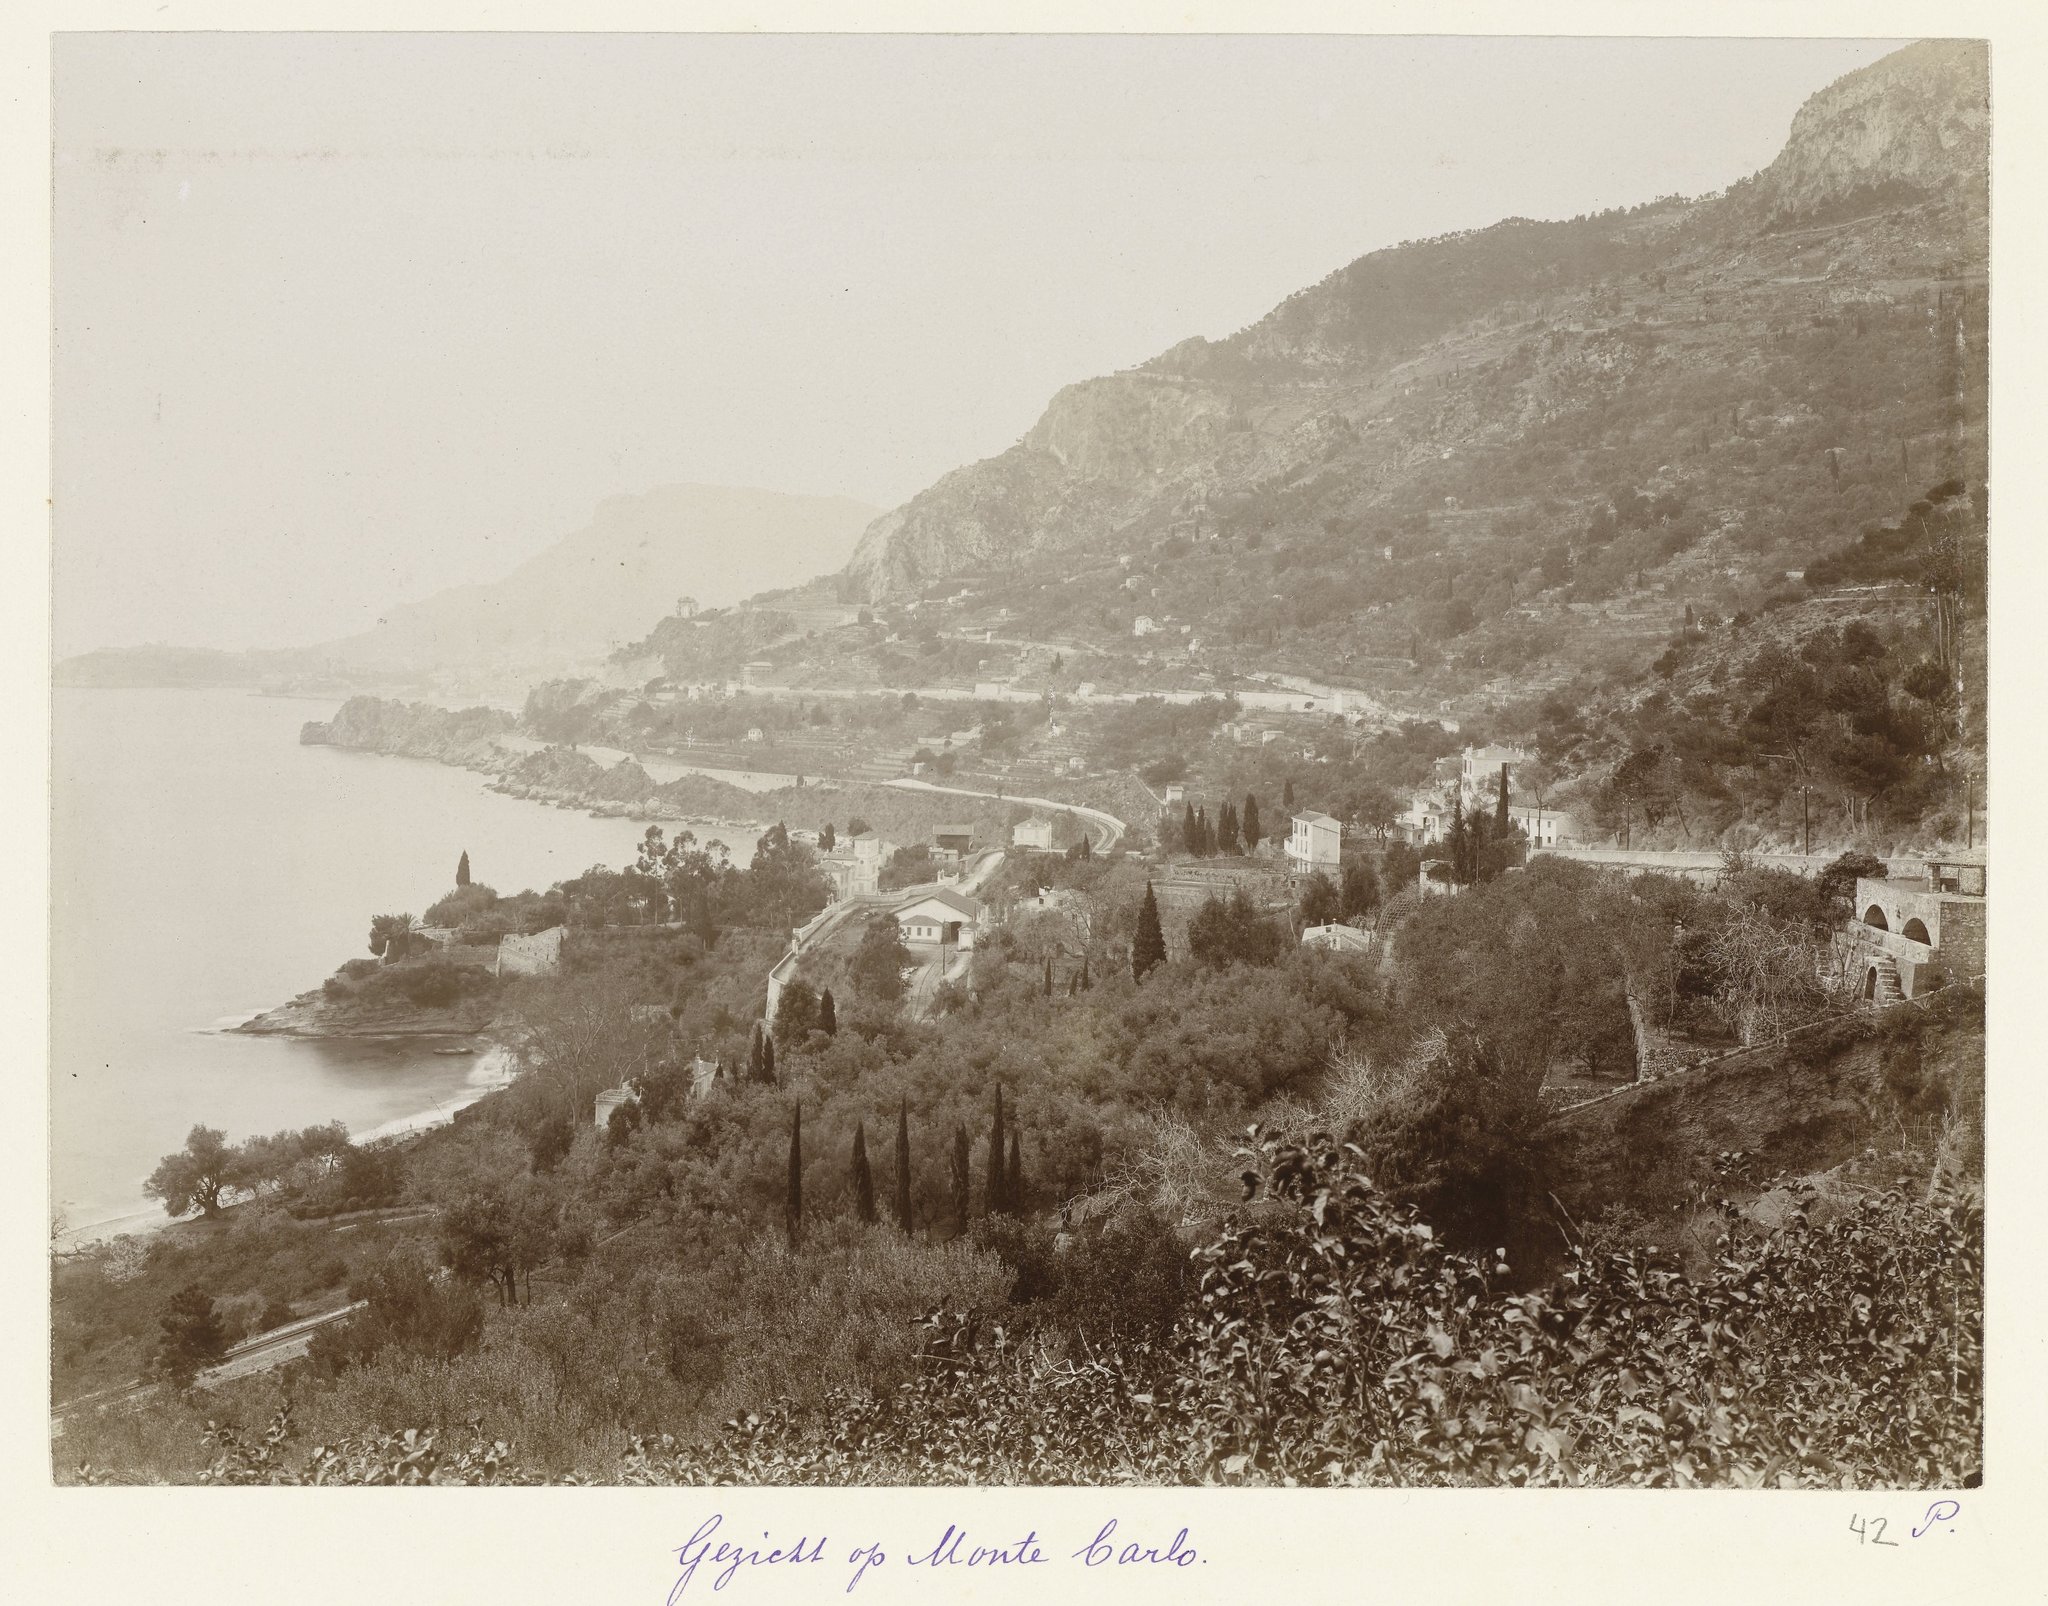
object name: photograph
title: Gezicht op Monte Carlo.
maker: henry pauw van wieldrecht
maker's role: fotograaf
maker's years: 1863-1912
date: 1886-1896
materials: cardboard, photographic support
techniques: albumen print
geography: monaco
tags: monte carlo